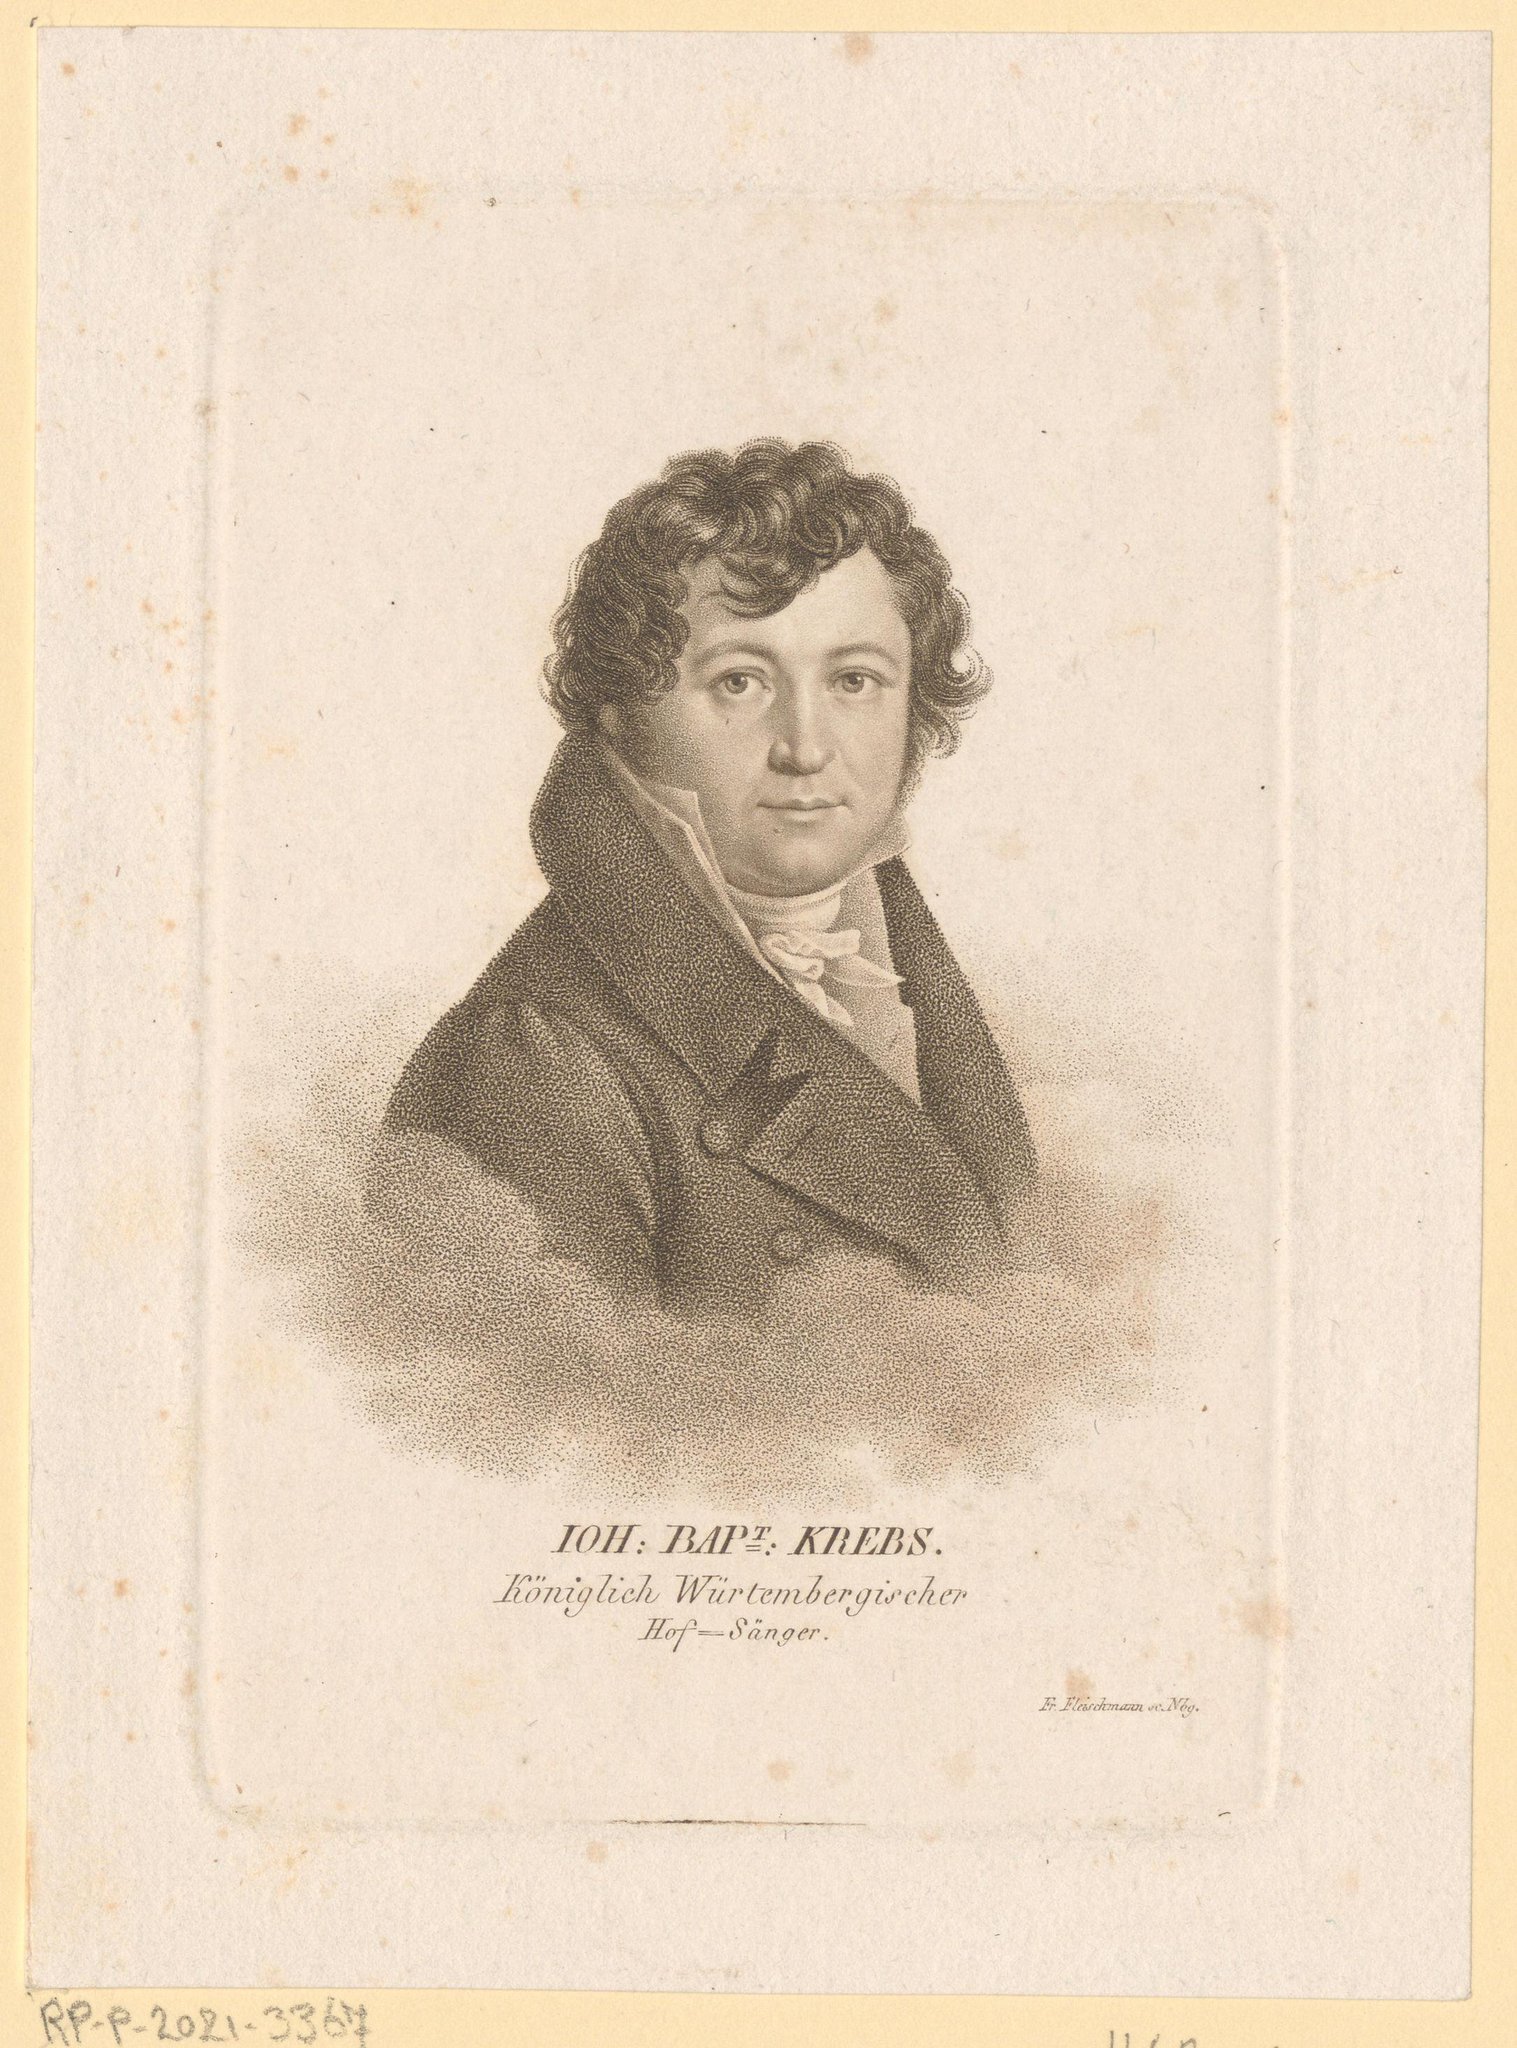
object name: print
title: Portret van Johann Baptist Krebs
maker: friedrich fleischmann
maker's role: print maker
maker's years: 1791-1834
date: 1801-1834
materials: paper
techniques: engraving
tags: historical persons